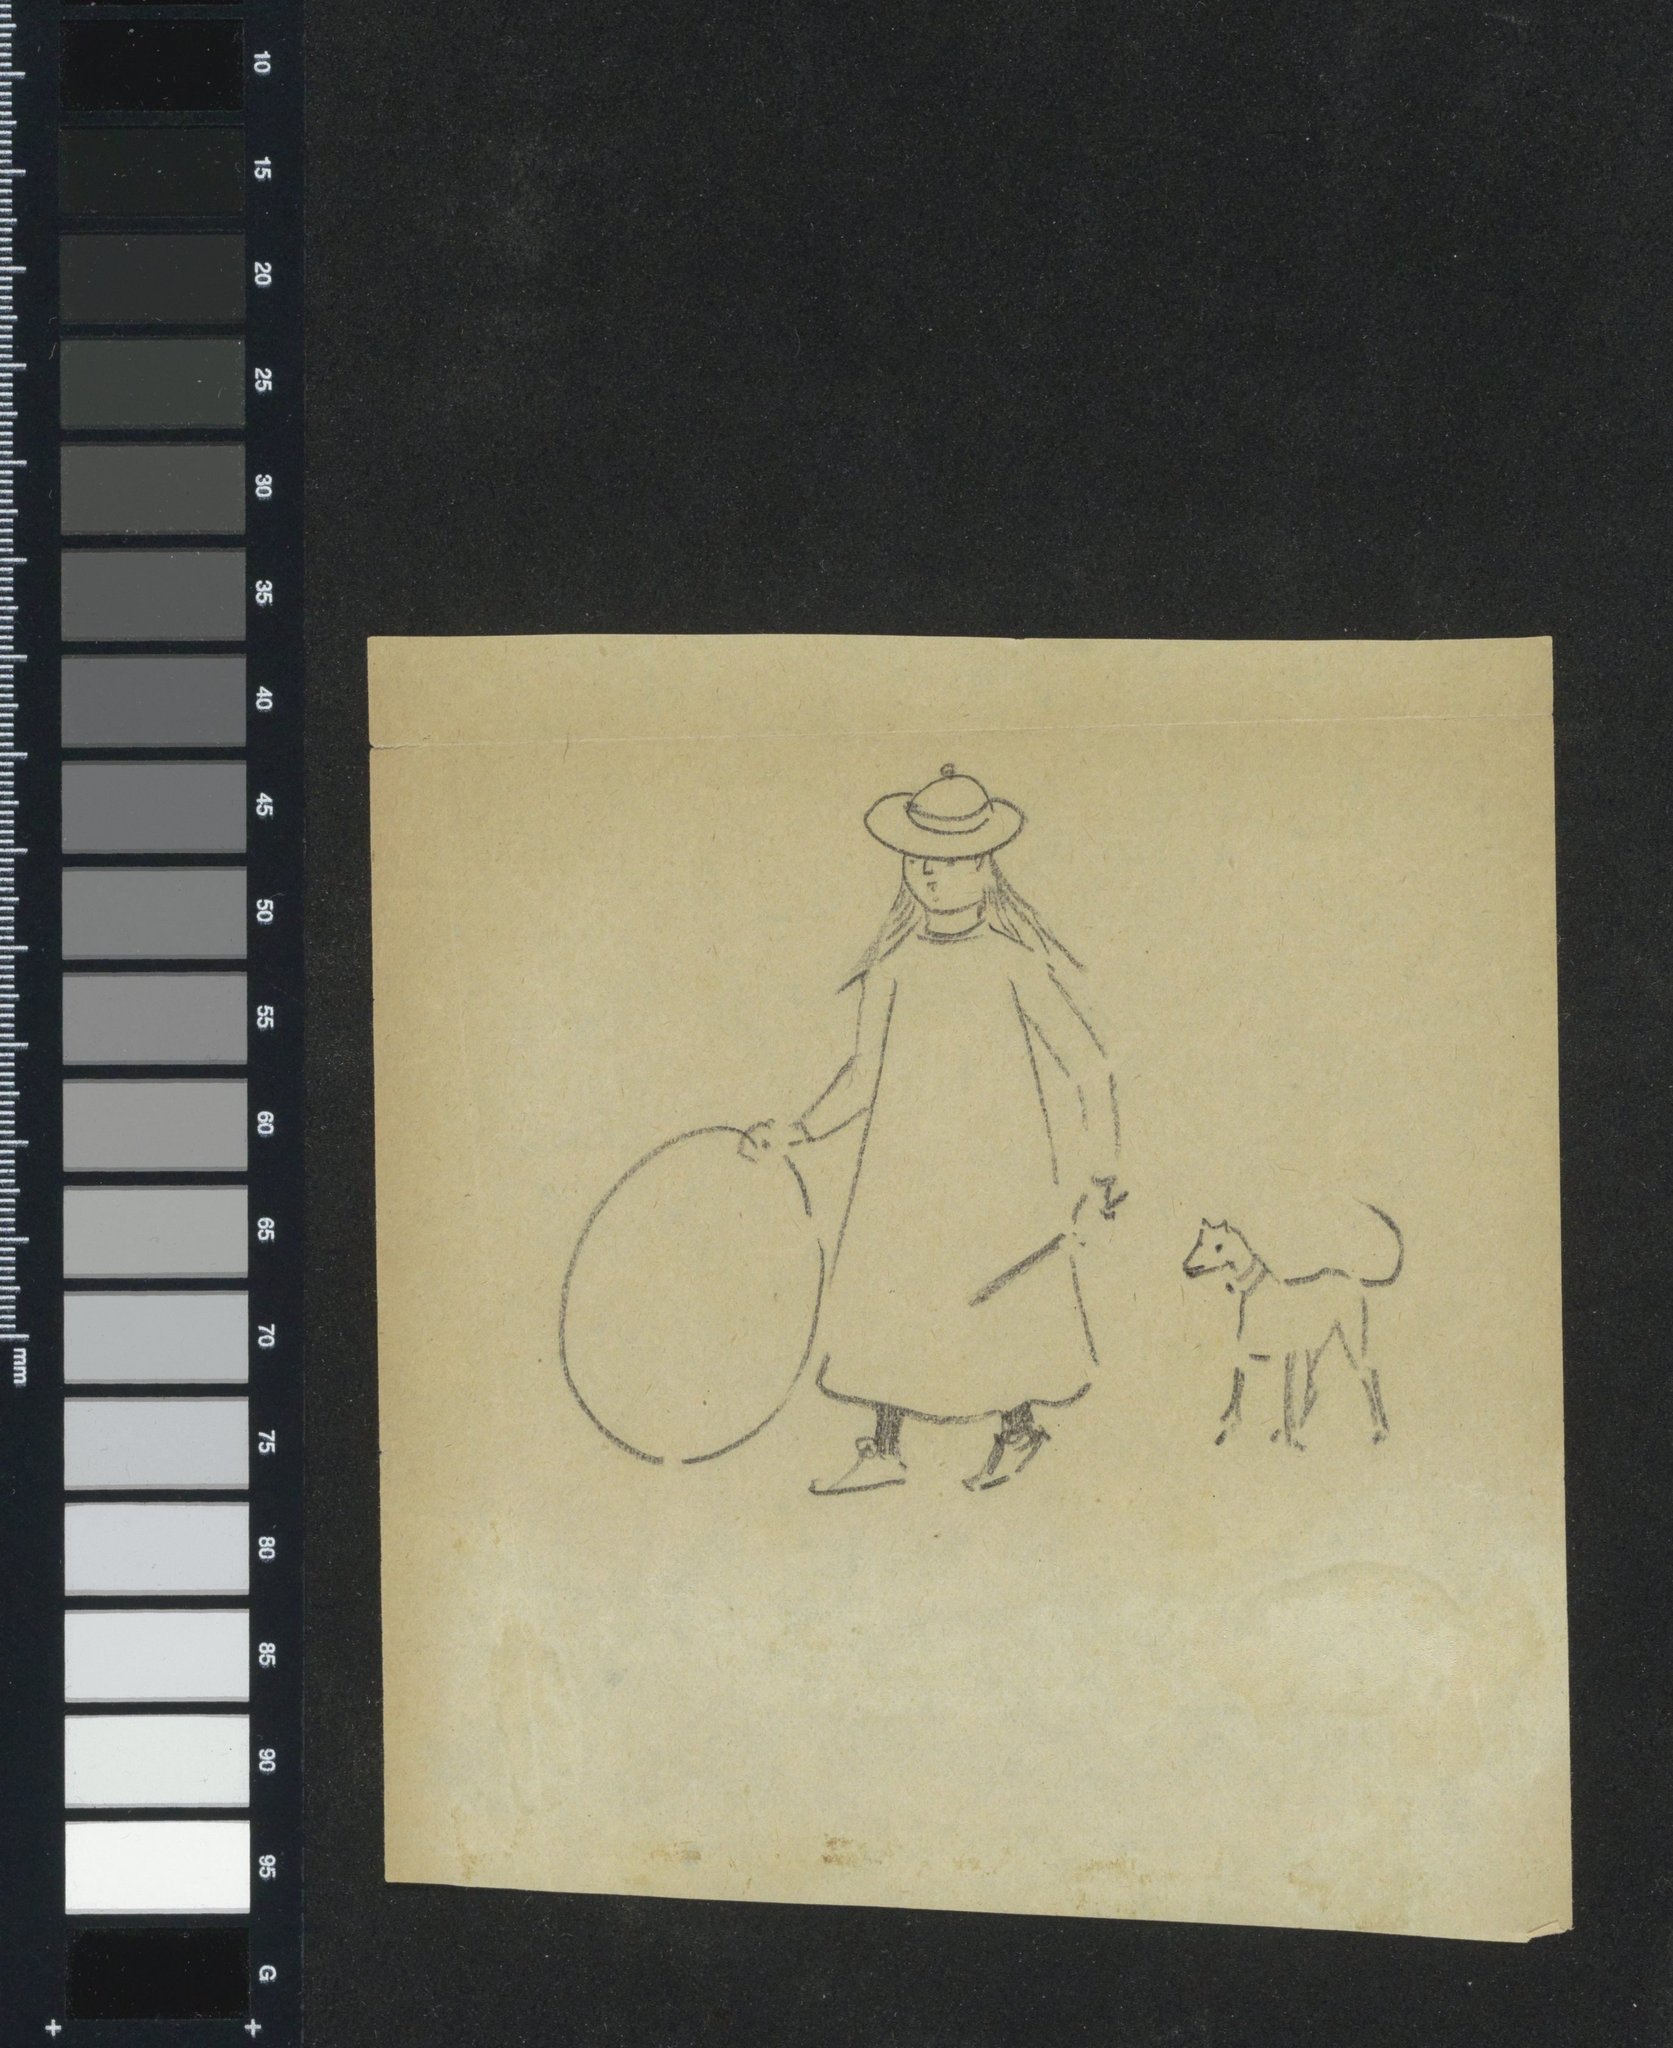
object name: drawing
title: Meisje met een hoepel en hond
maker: gerrit willem dijsselhof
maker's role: designer, draughtsman, print maker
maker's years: 1866-1924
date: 1904-1906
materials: chalk, paper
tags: girl (child between toddler and youth), (bowling a) hoop